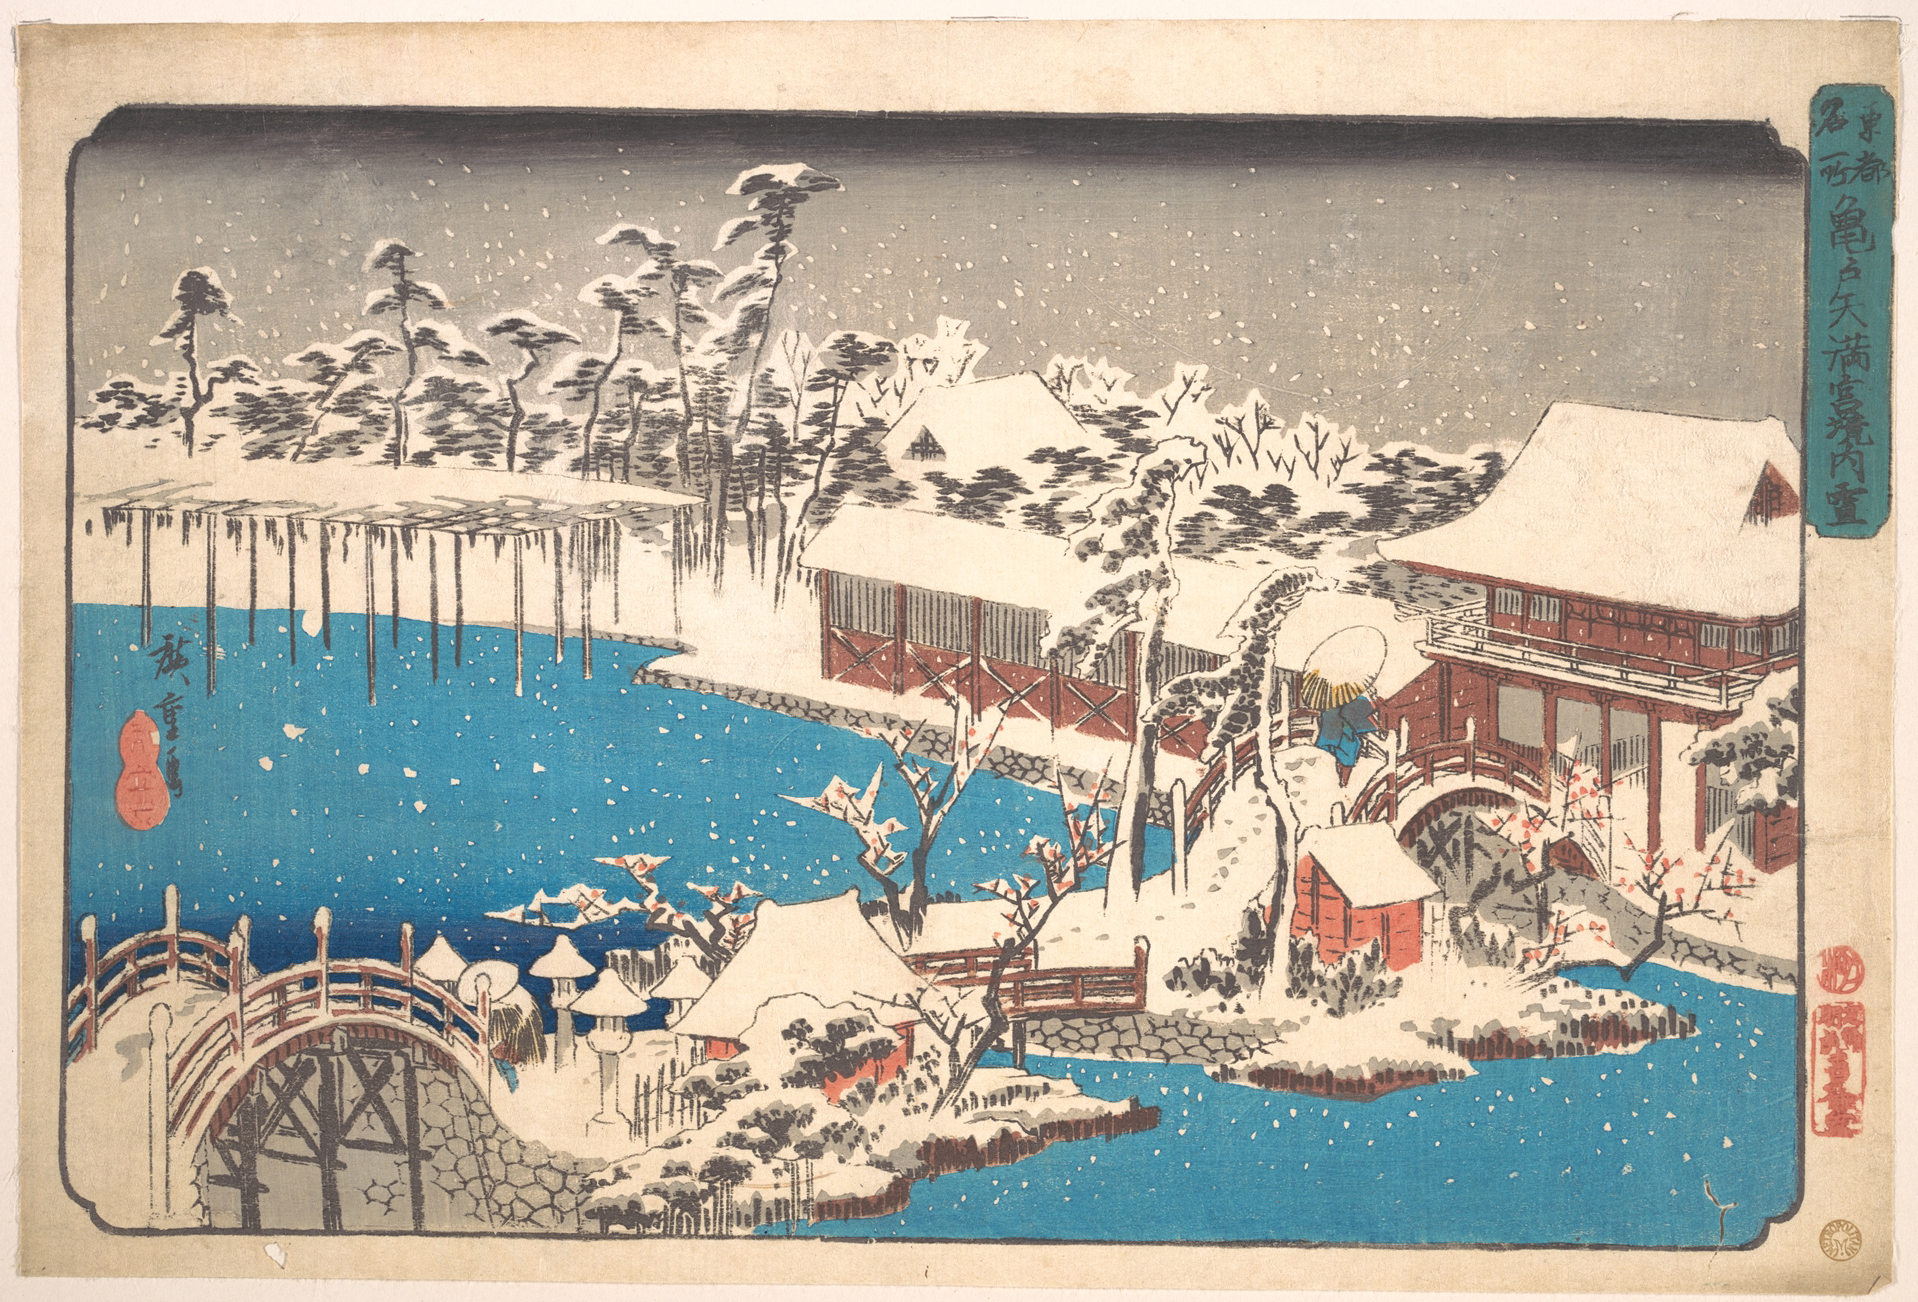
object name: print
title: Kameido Tenmangu Keidai no Yuki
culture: japanese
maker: utagawa hiroshige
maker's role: artist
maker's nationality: japanese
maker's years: 1797-1858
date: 1833-1834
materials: ink, paper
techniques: woodblock print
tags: houses,bridges,trees,snow